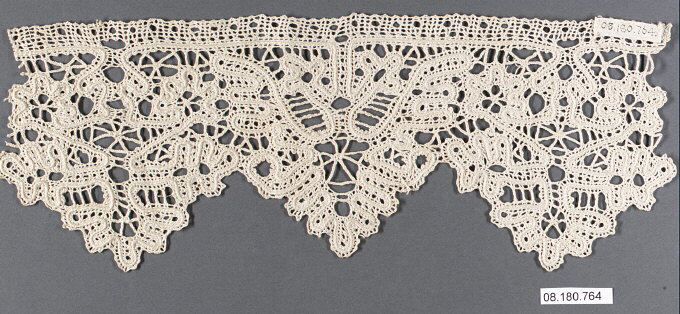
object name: fragment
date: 1801-1900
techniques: lace